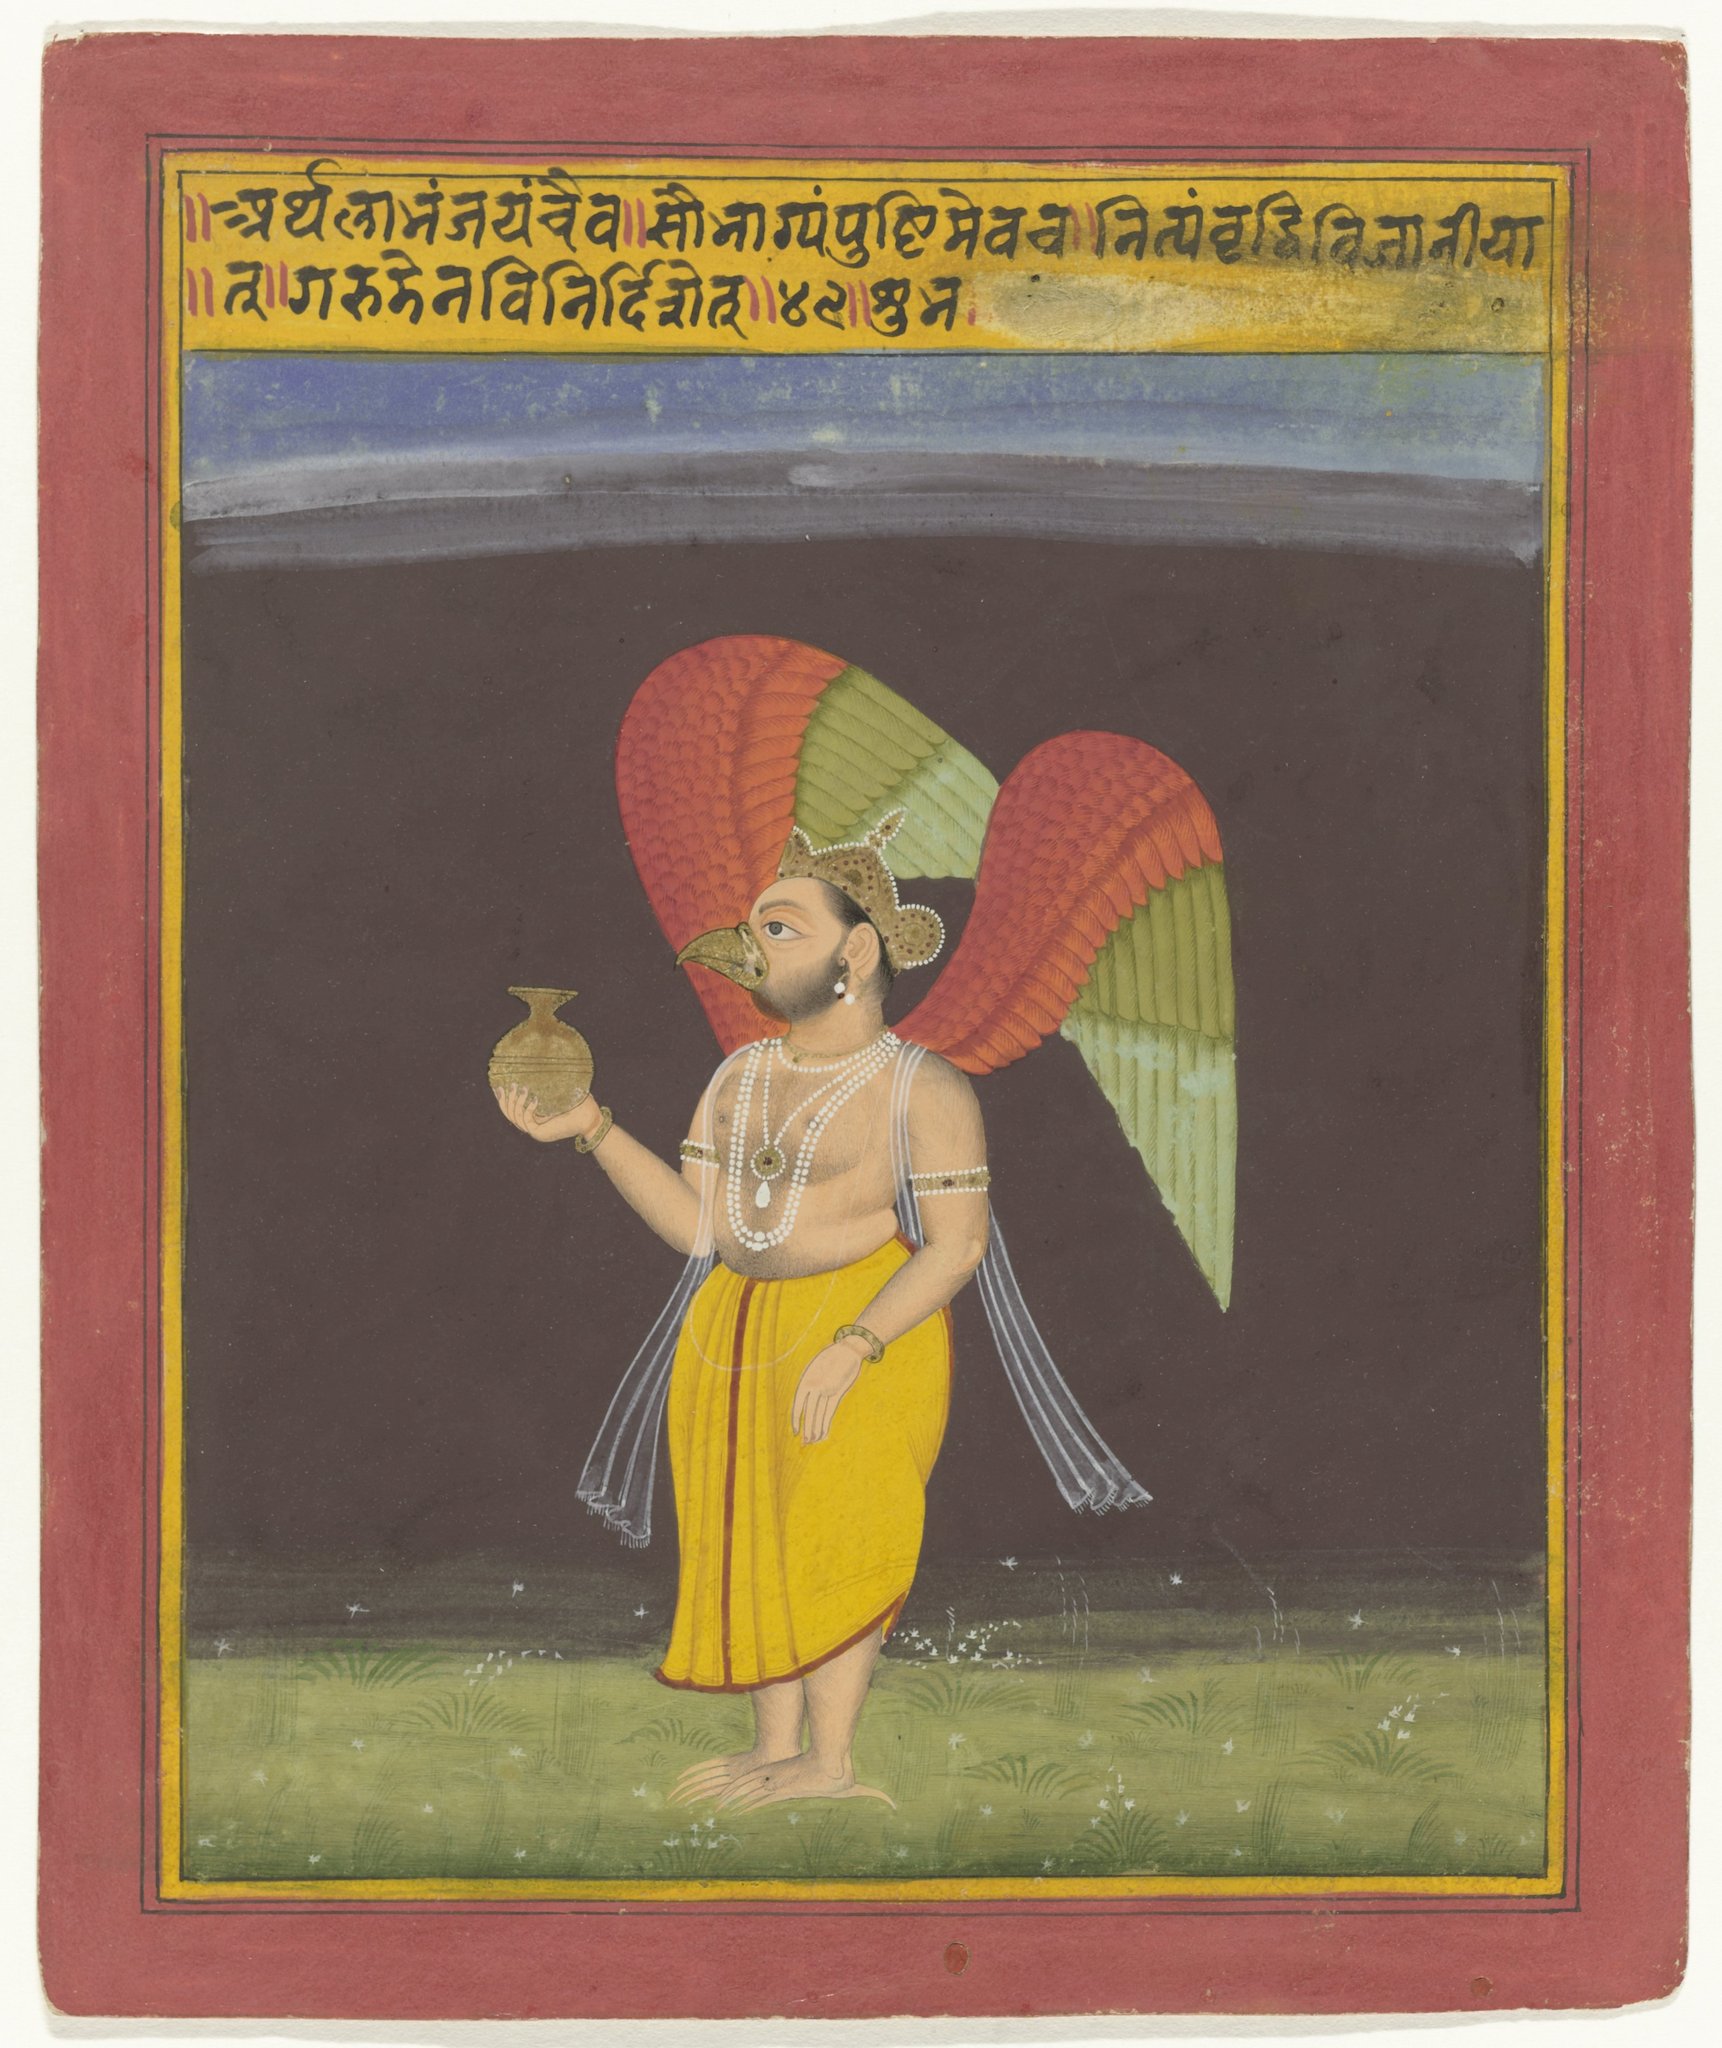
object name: drawing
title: Garuda (Book of Dreams)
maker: Anonymous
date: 1710-1734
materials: paper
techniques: brush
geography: mewar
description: Tegen een donkere achtergrond staat een halfnaakte mannelijke figuur met de snavel, vleugels en poten van een vogel in profiel naar links, in zijn rechterhand houdt hij een potje vast. Rond de voorstelling een smalle bies in geel met zwarte kaderlijnen en een rode rand met een zwarte kaderlijn; boven de voorstelling een gele bies met tekst in Indiaas schrift in zwart en rood.